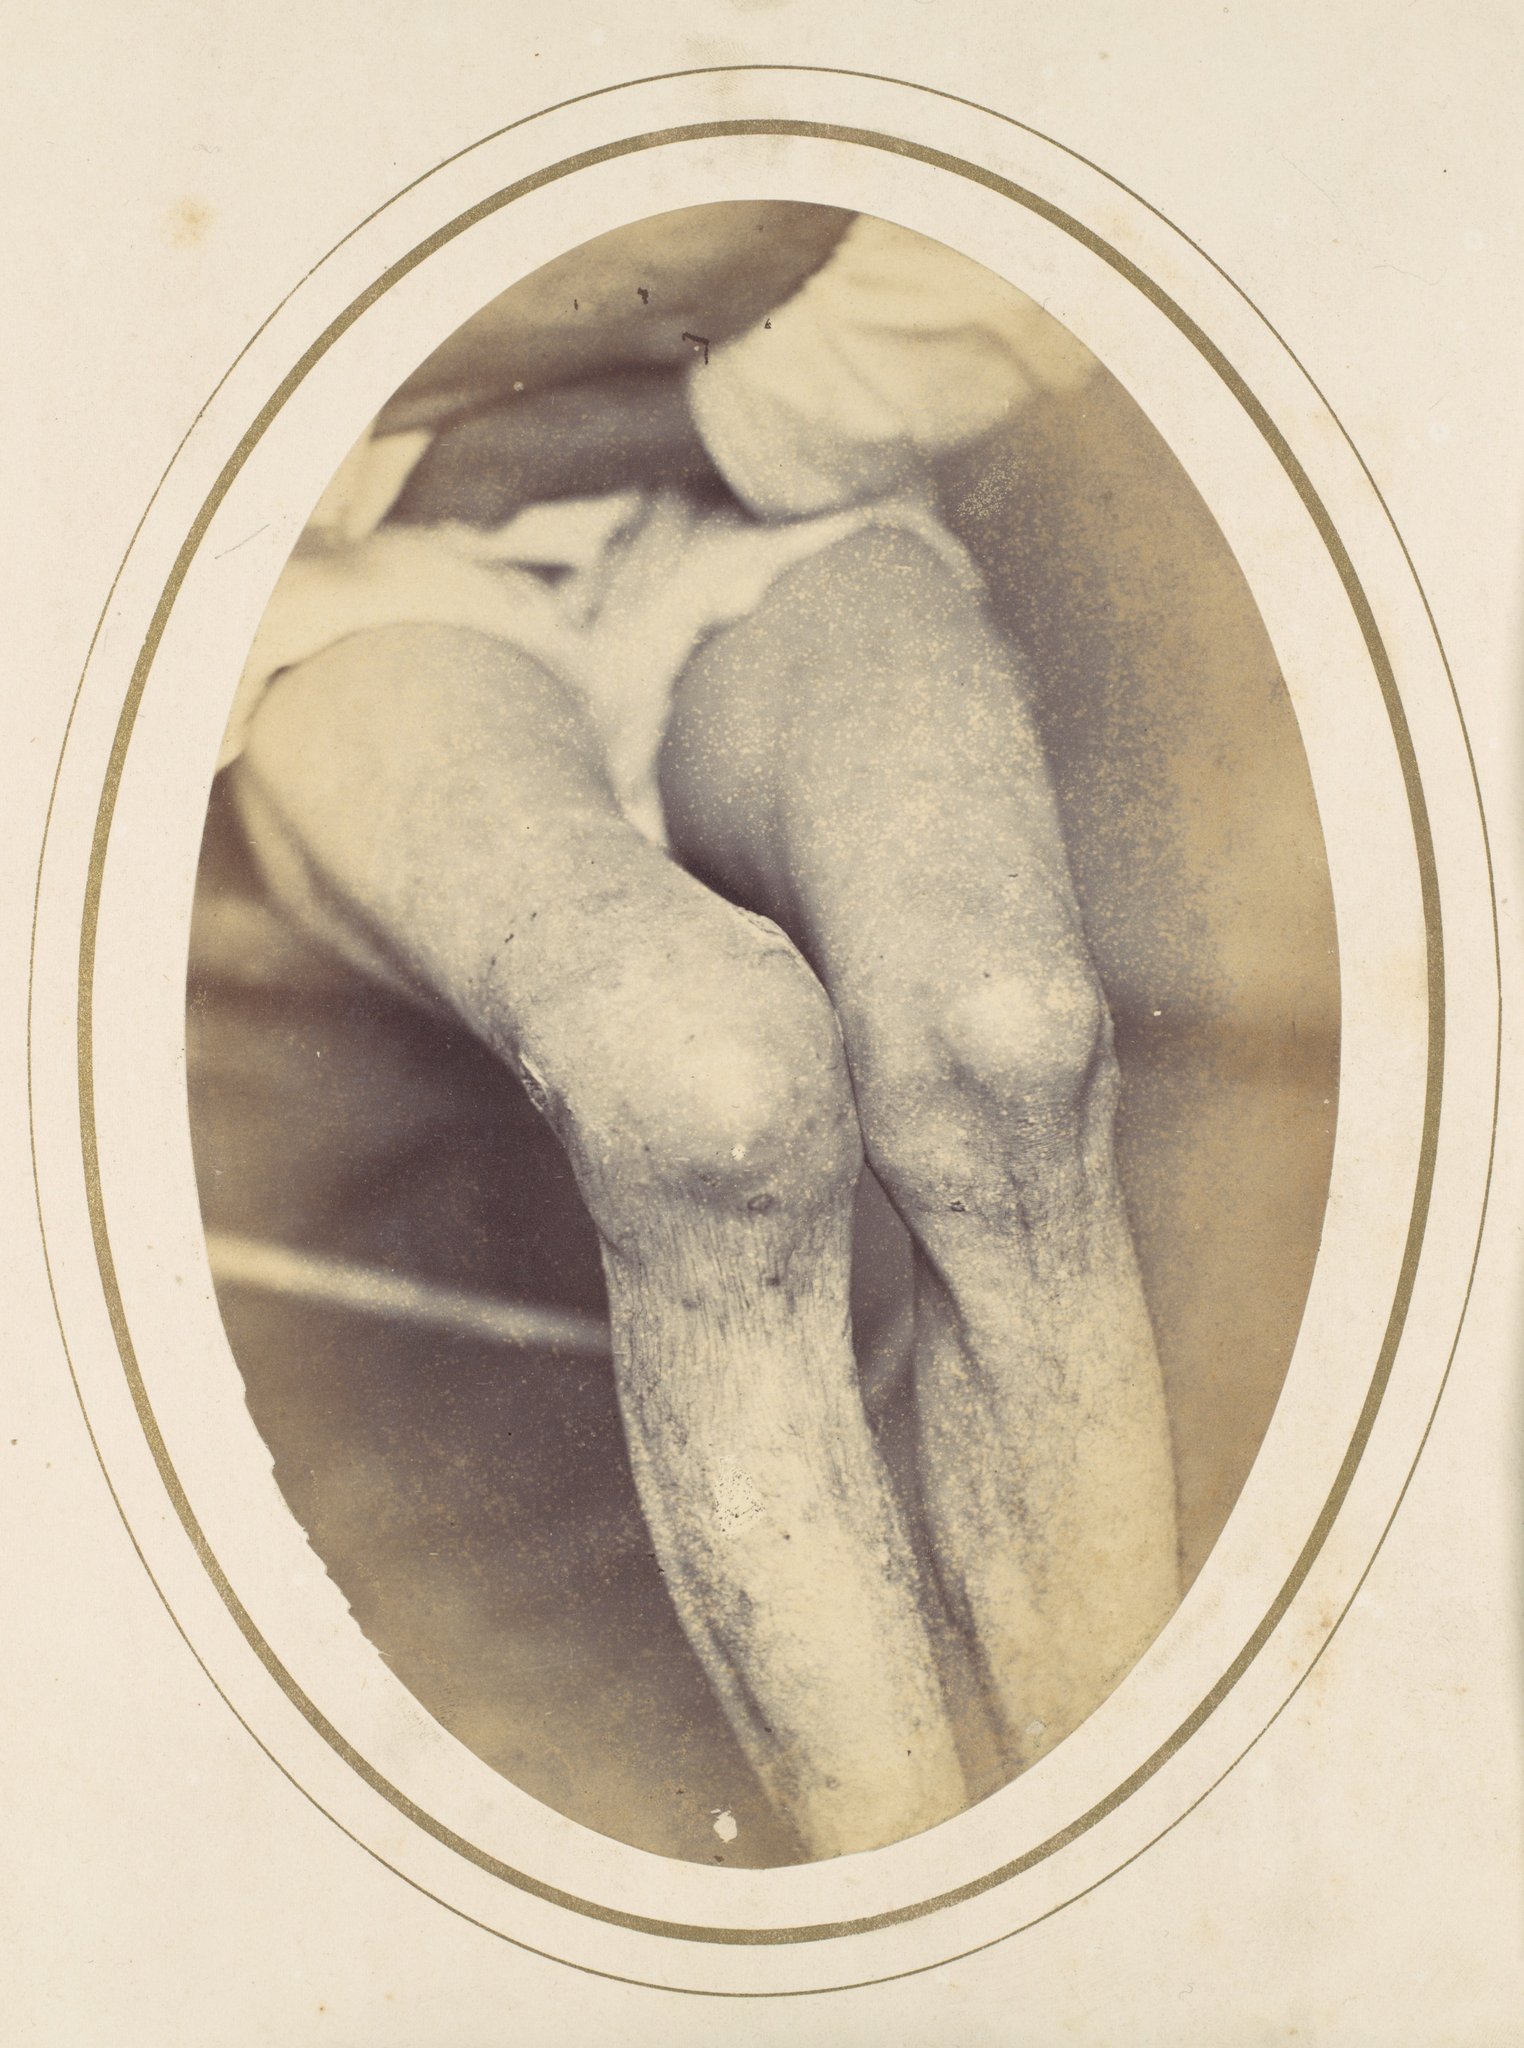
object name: photograph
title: Frederick Hohmann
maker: reed brockway bontecou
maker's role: artist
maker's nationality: american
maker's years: 1824-1907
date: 1865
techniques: albumen silver print, glass negative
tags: american civil war,men